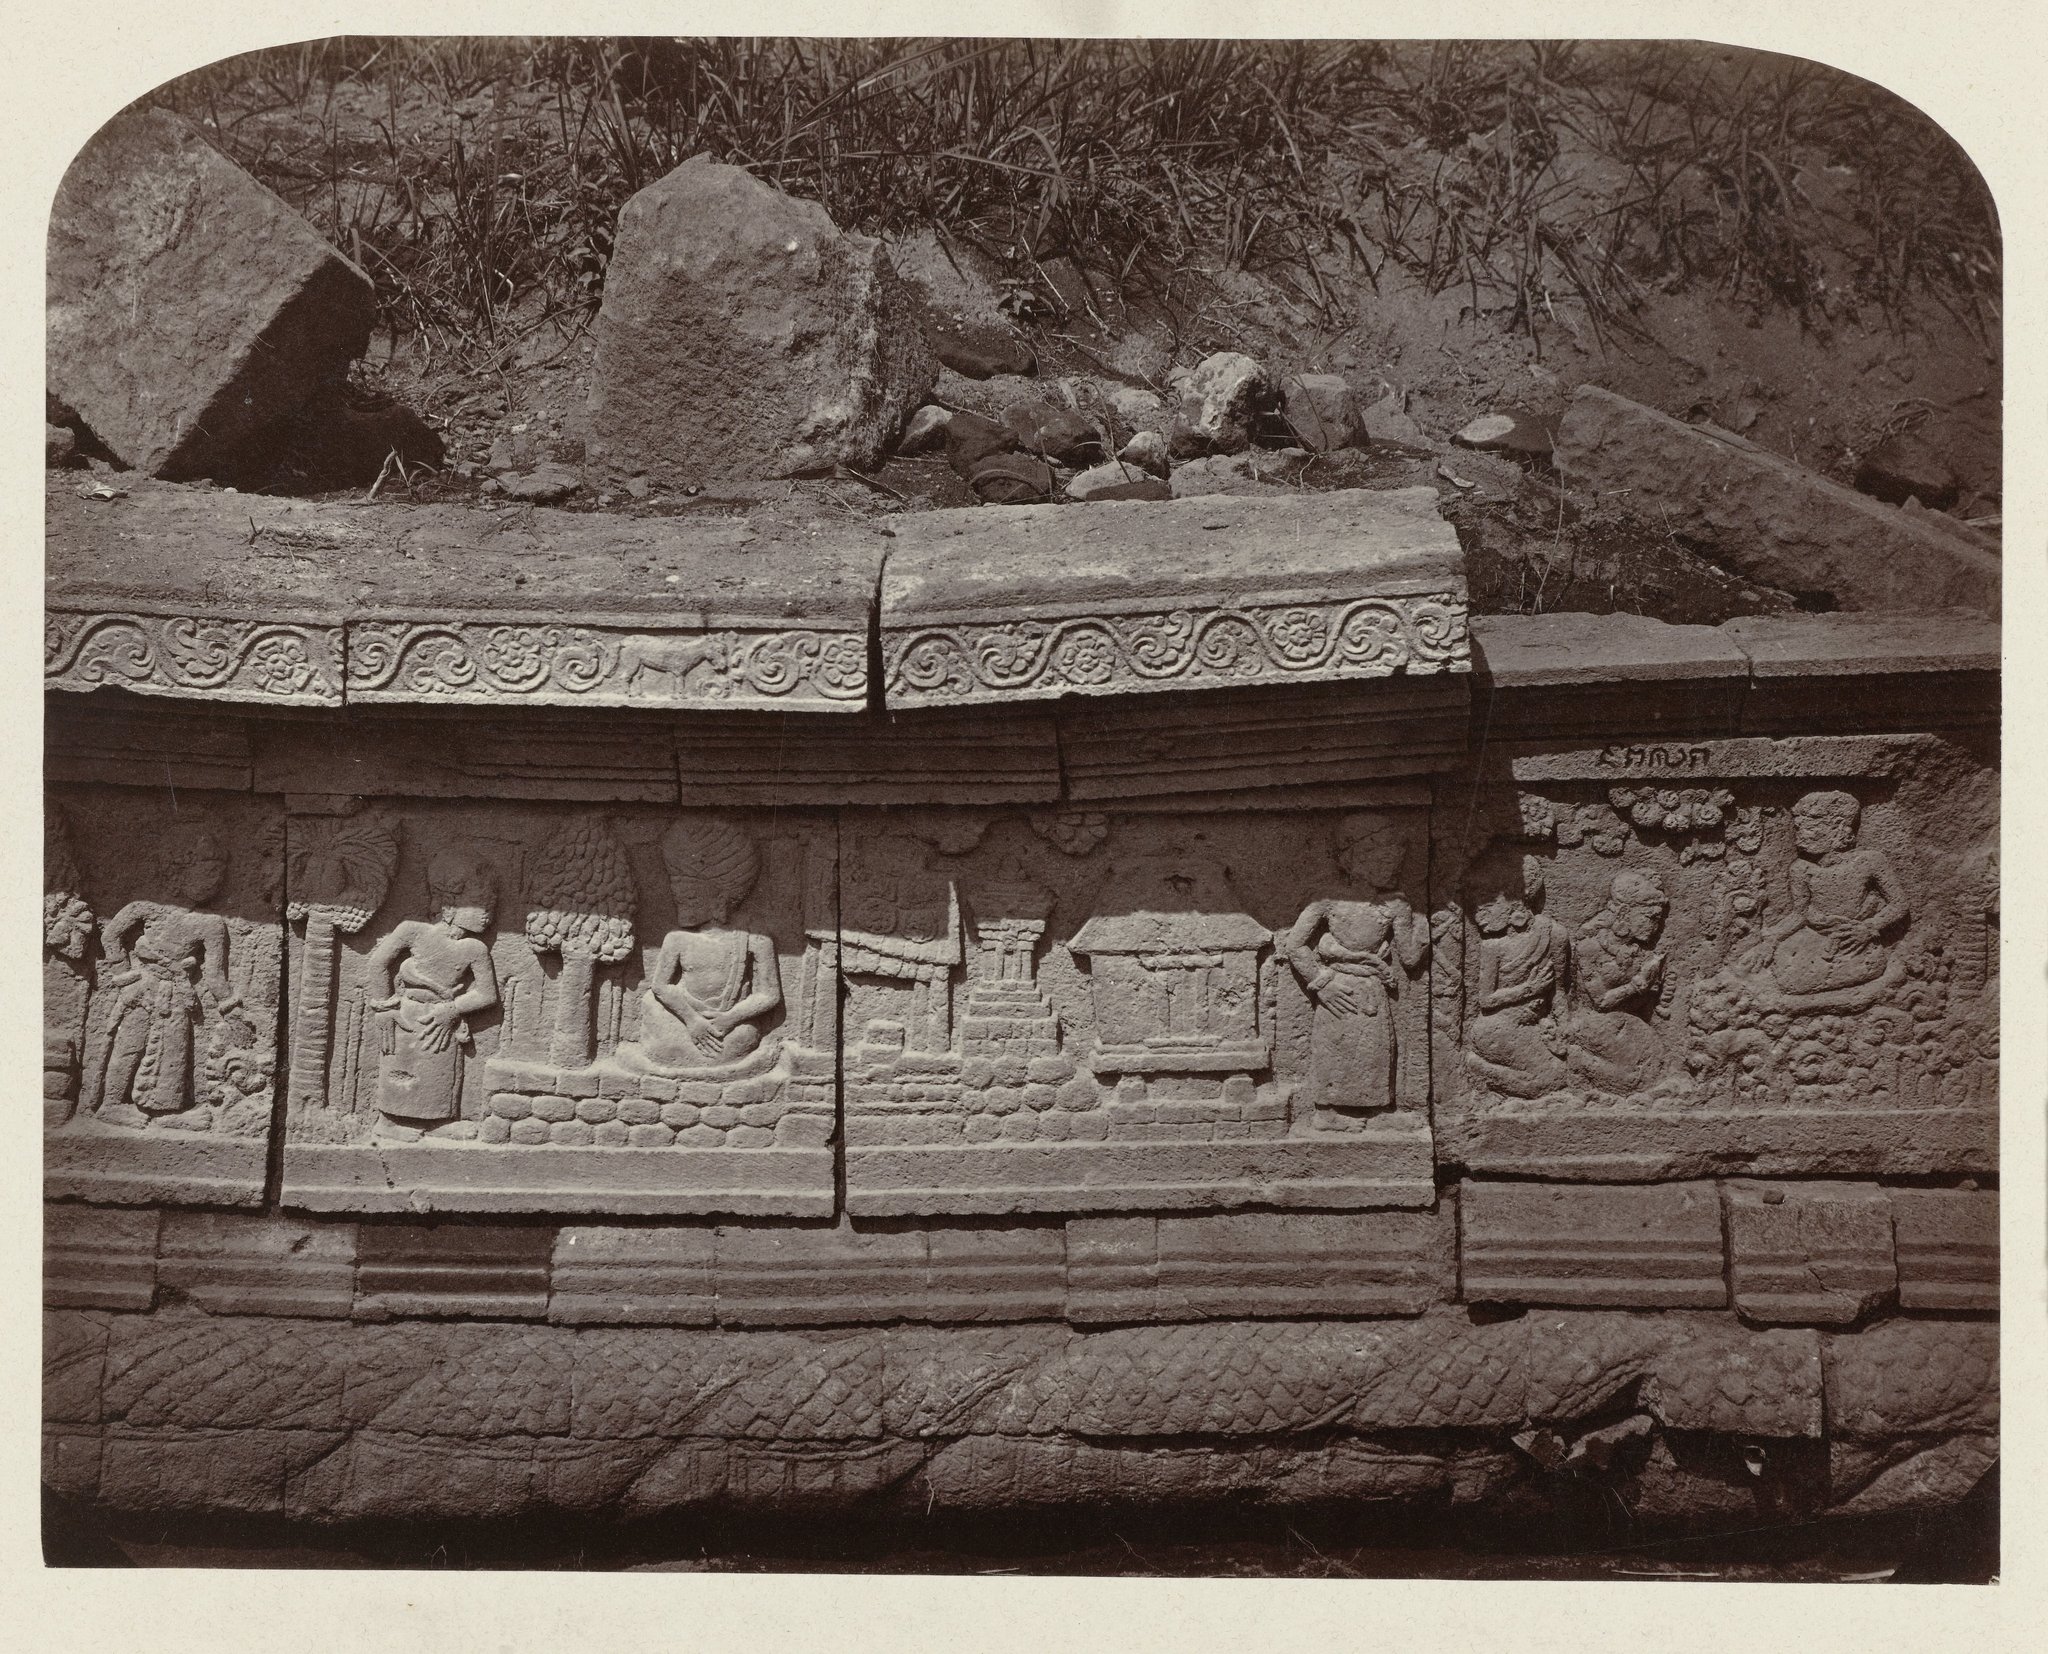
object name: photograph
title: Basrelief op het voetstuk eener pendopo (?) (westzijde). Panataran (r. Kediri)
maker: isidore kinsbergen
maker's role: fotograaf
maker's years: 1821-1905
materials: cardboard, paper, photographic support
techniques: albumen print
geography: java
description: Candi Panataran (Temple Complex), Pendopo Terrace, unidentified reliefs 57-61 (inscrition above no 60 reads niraksara), west side. Panataran, Blitar district, East Java province, 1375 AD